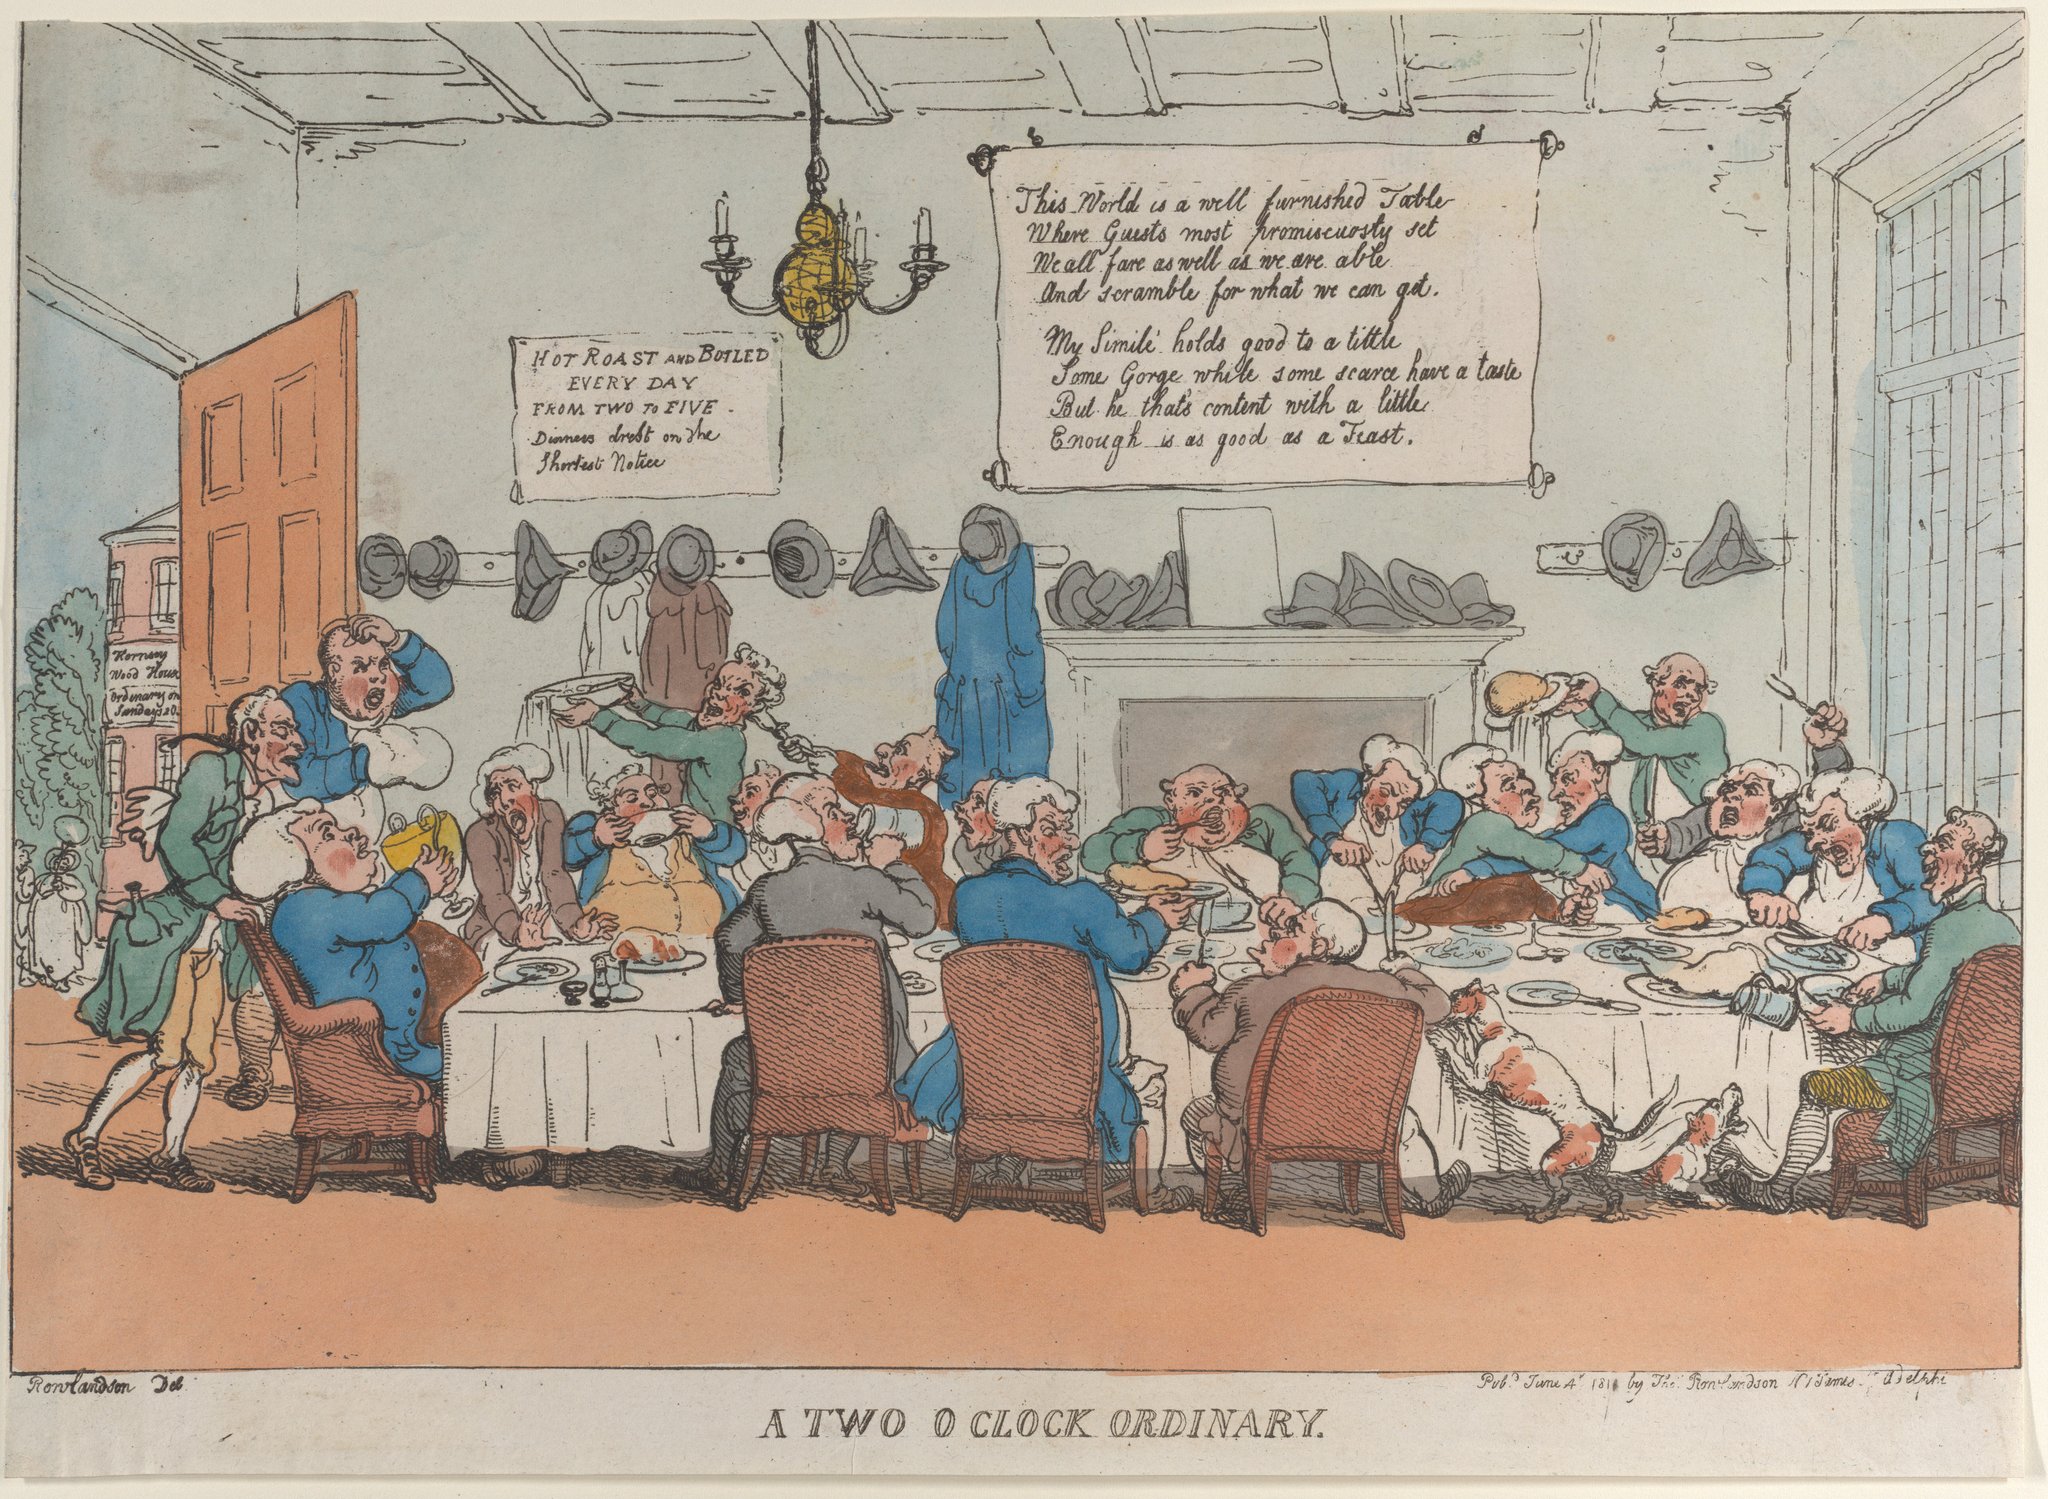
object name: print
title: A Two O'Clock Ordinary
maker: thomas rowlandson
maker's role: artist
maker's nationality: british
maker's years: 1757-1827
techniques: etching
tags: satire,men,dogs,dining